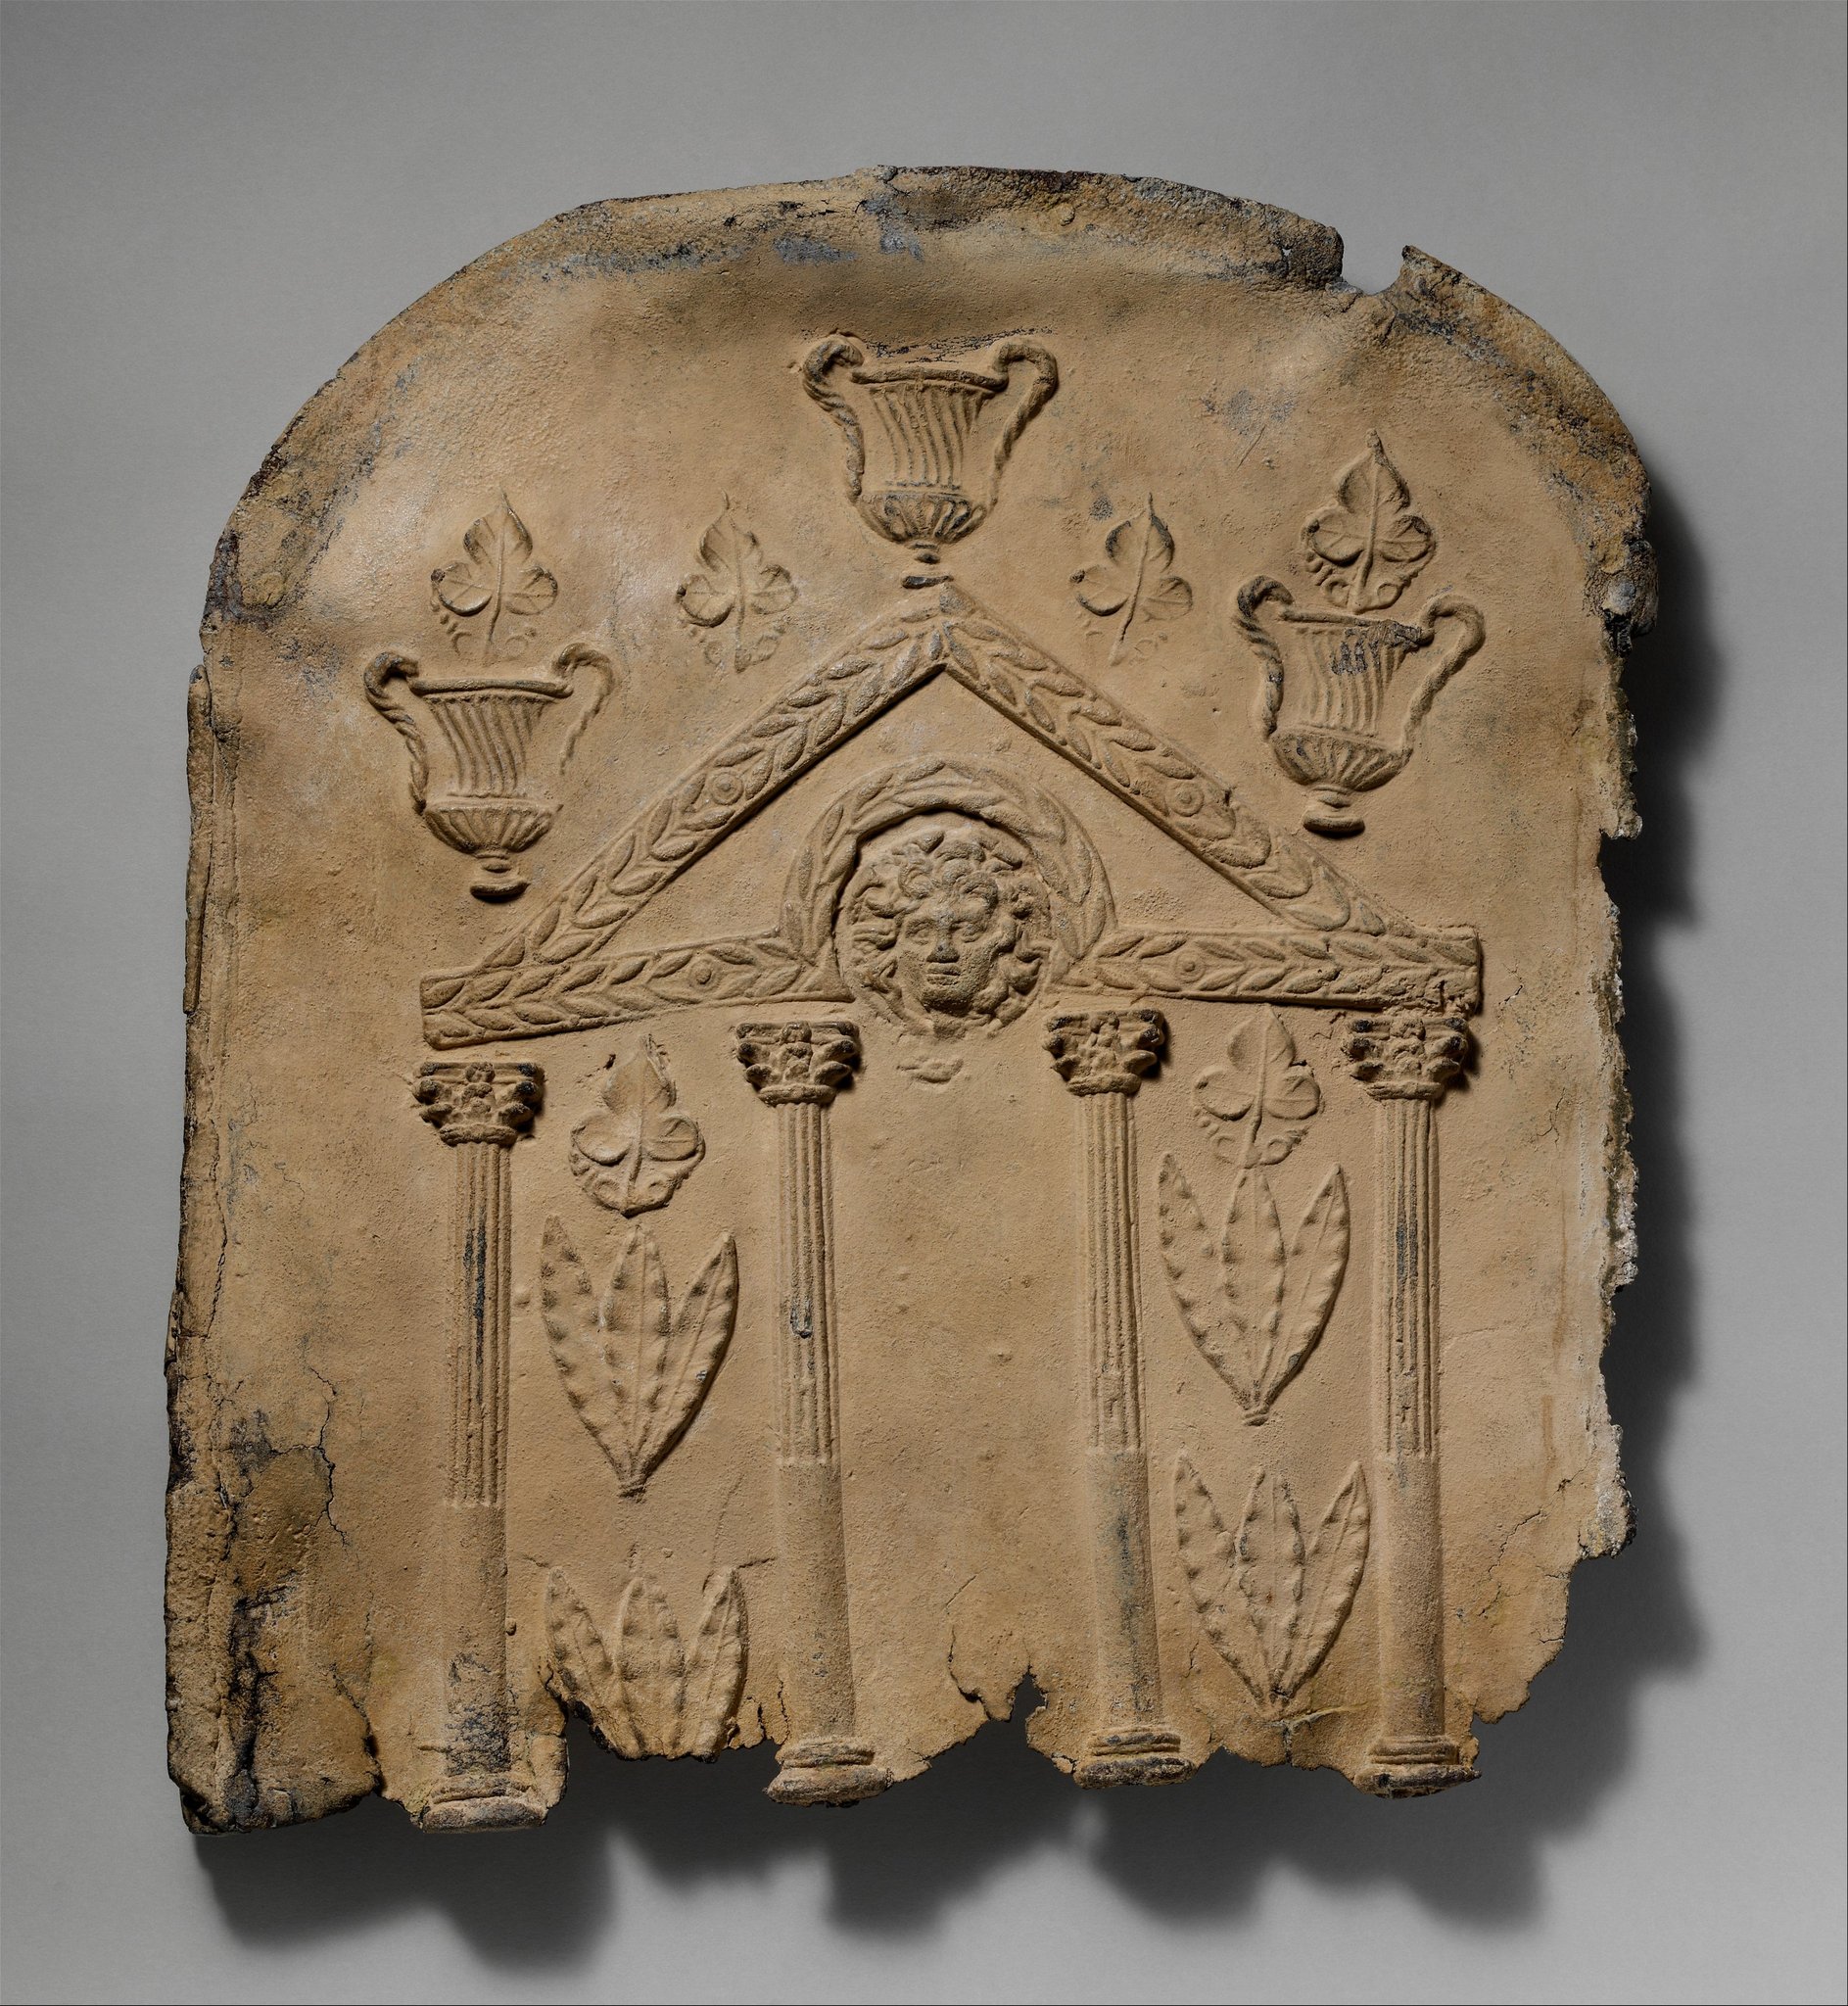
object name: sarcophagus, lead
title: Lid and end panels of a lead sarcophagus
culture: roman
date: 167-266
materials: lead